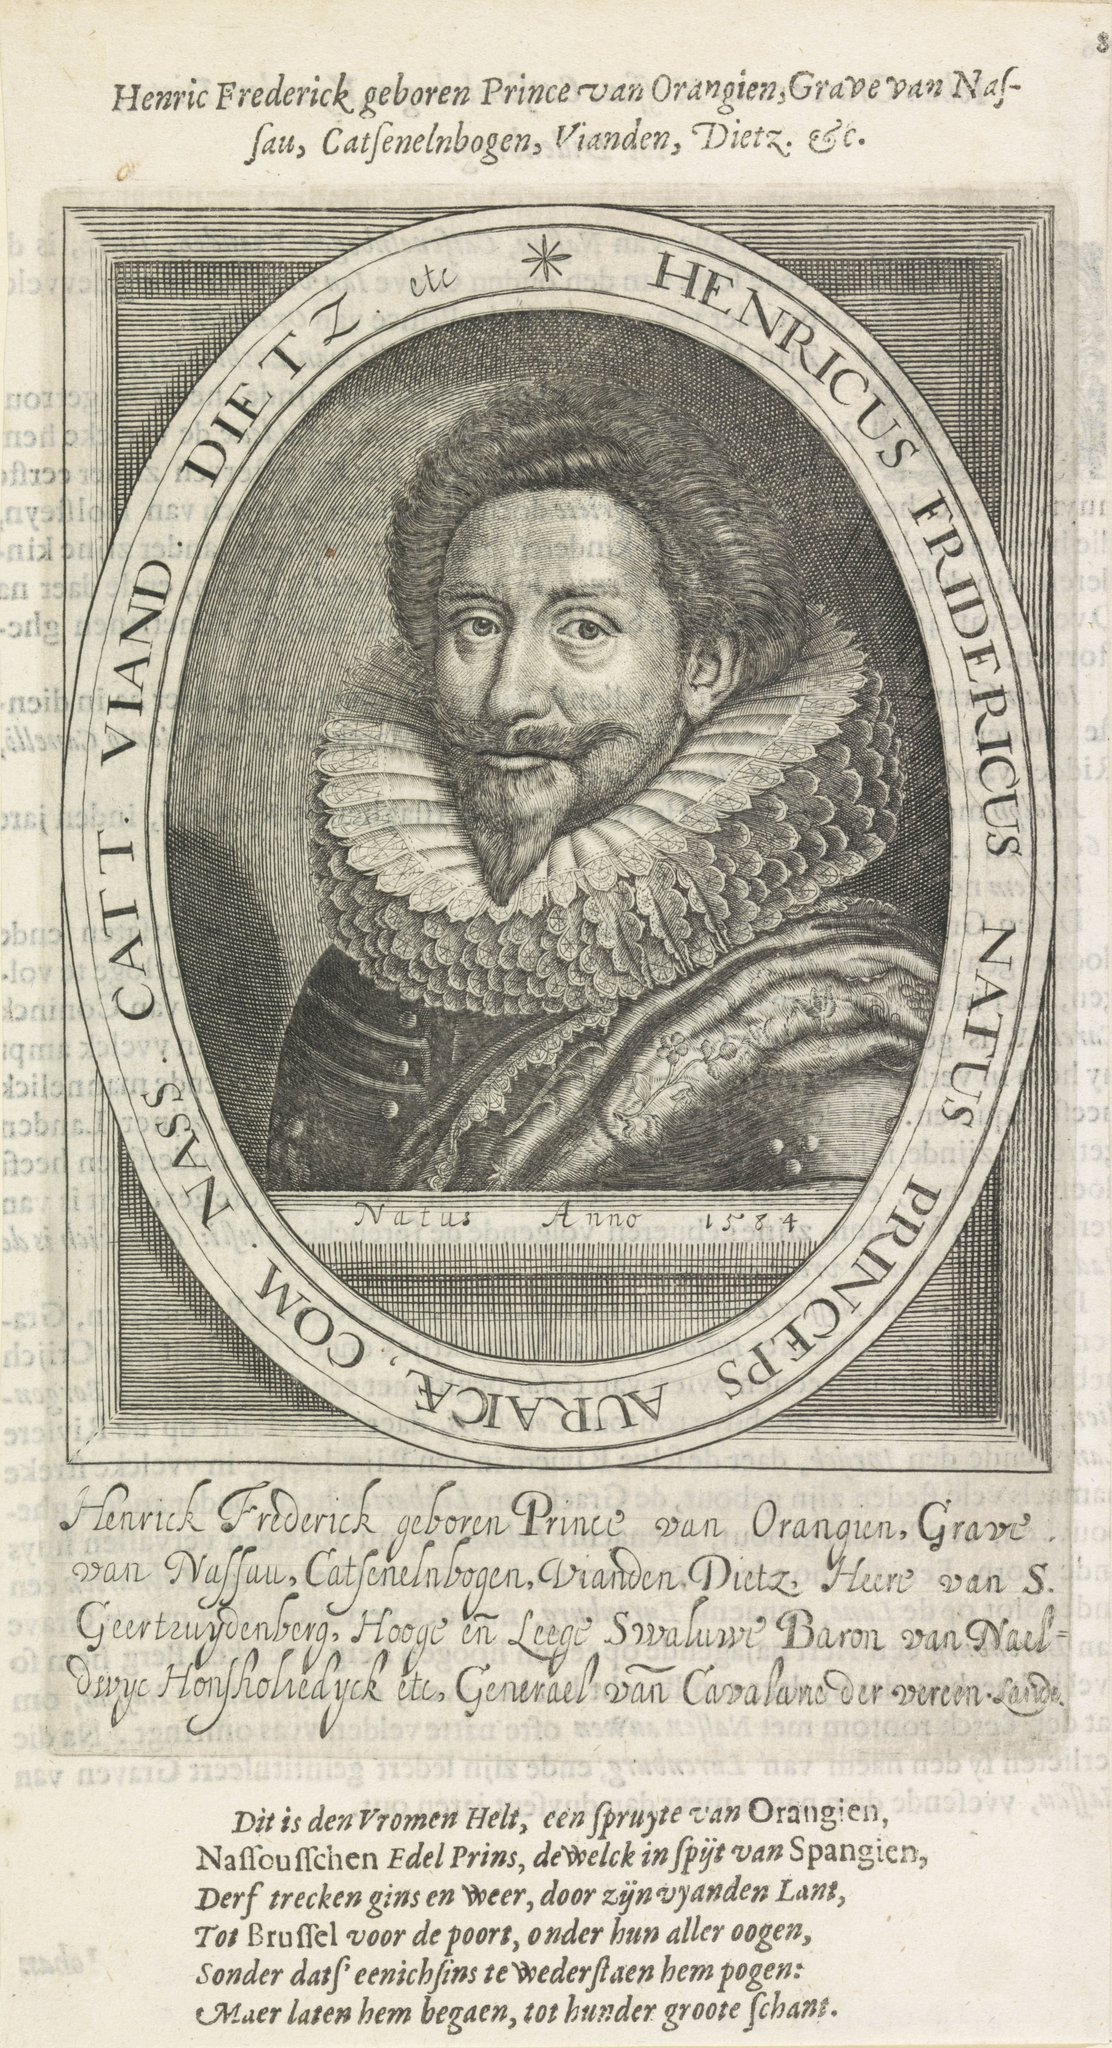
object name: book illustration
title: Portret van Frederik Hendrik, prins van Oranje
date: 1625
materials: paper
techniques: engraving, etching, letterpress printing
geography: delft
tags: delft, frederick henry (prince of orange)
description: De hier vermelde titel verwijst naar de hoogst verkregen titel van de geportretteerde, niet per se naar de titel die de geportretteerde op deze voorstelling draagt. Prent uit: Clerck, Nicolaes de. Princelyck cabinet. Verthoonende t'leven afcomste ende afbeeldingen, der voornaemste vorstē (...) van Europa jegenwoordig regierende. Delft: Nicolaes de Clerck, 1625.